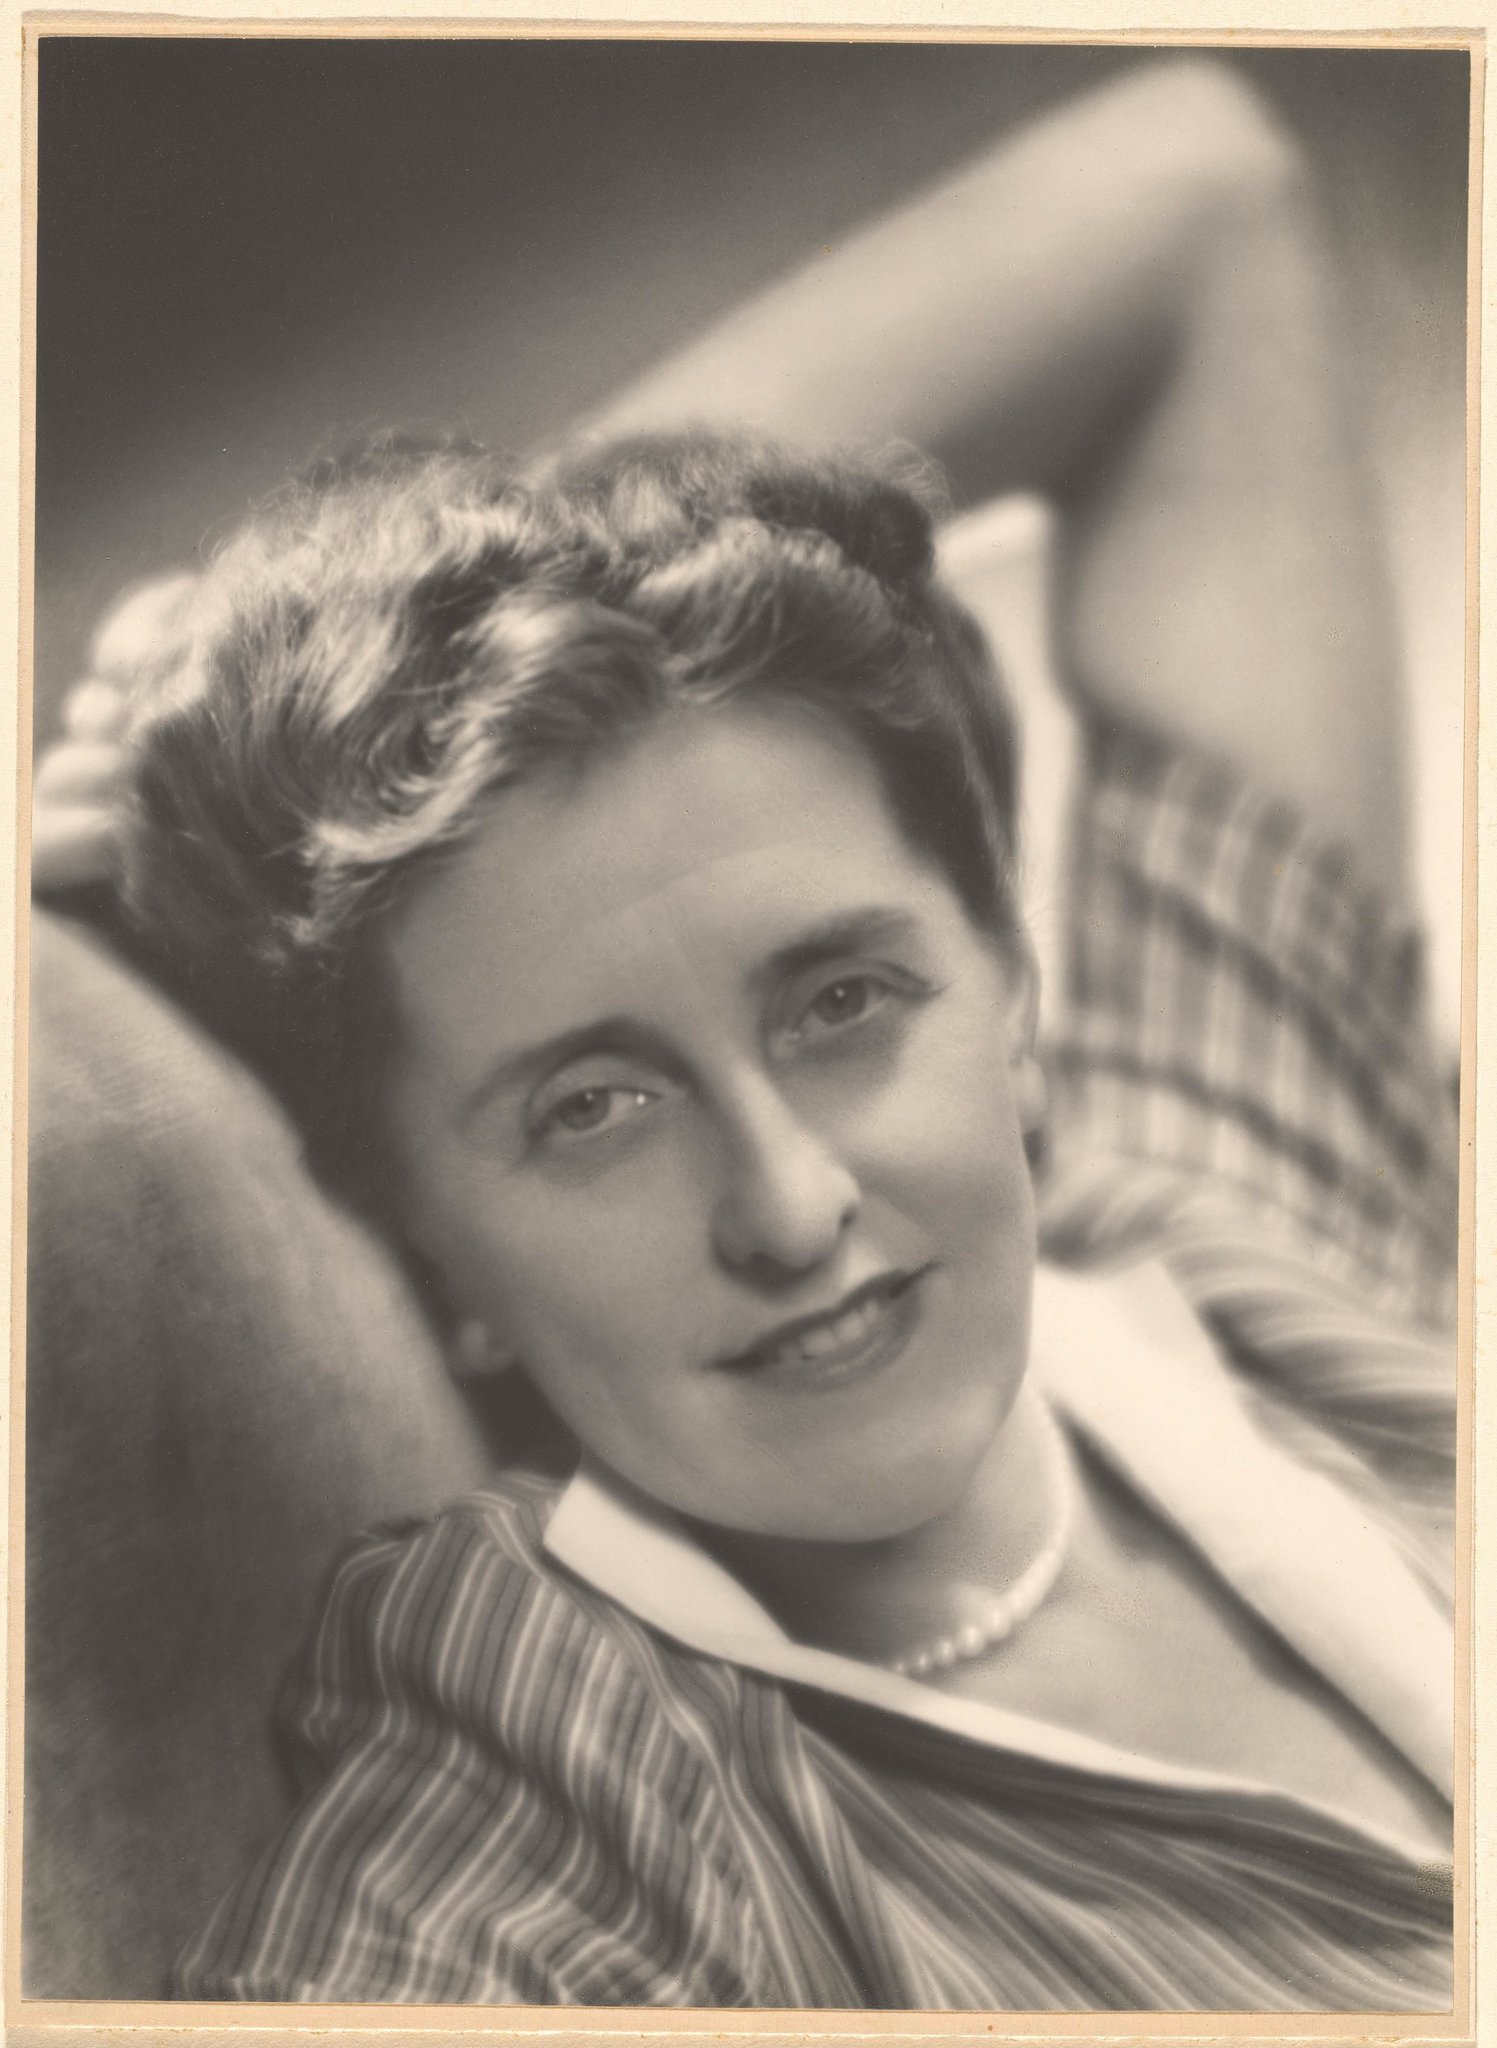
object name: photograph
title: Portret van actrice Loudi Nijhoff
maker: jacob merkelbach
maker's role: fotograaf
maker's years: 1877-1942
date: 1930-1945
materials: cardboard, photographic support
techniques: gelatin silver print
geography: amsterdam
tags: portrait of actor, actress